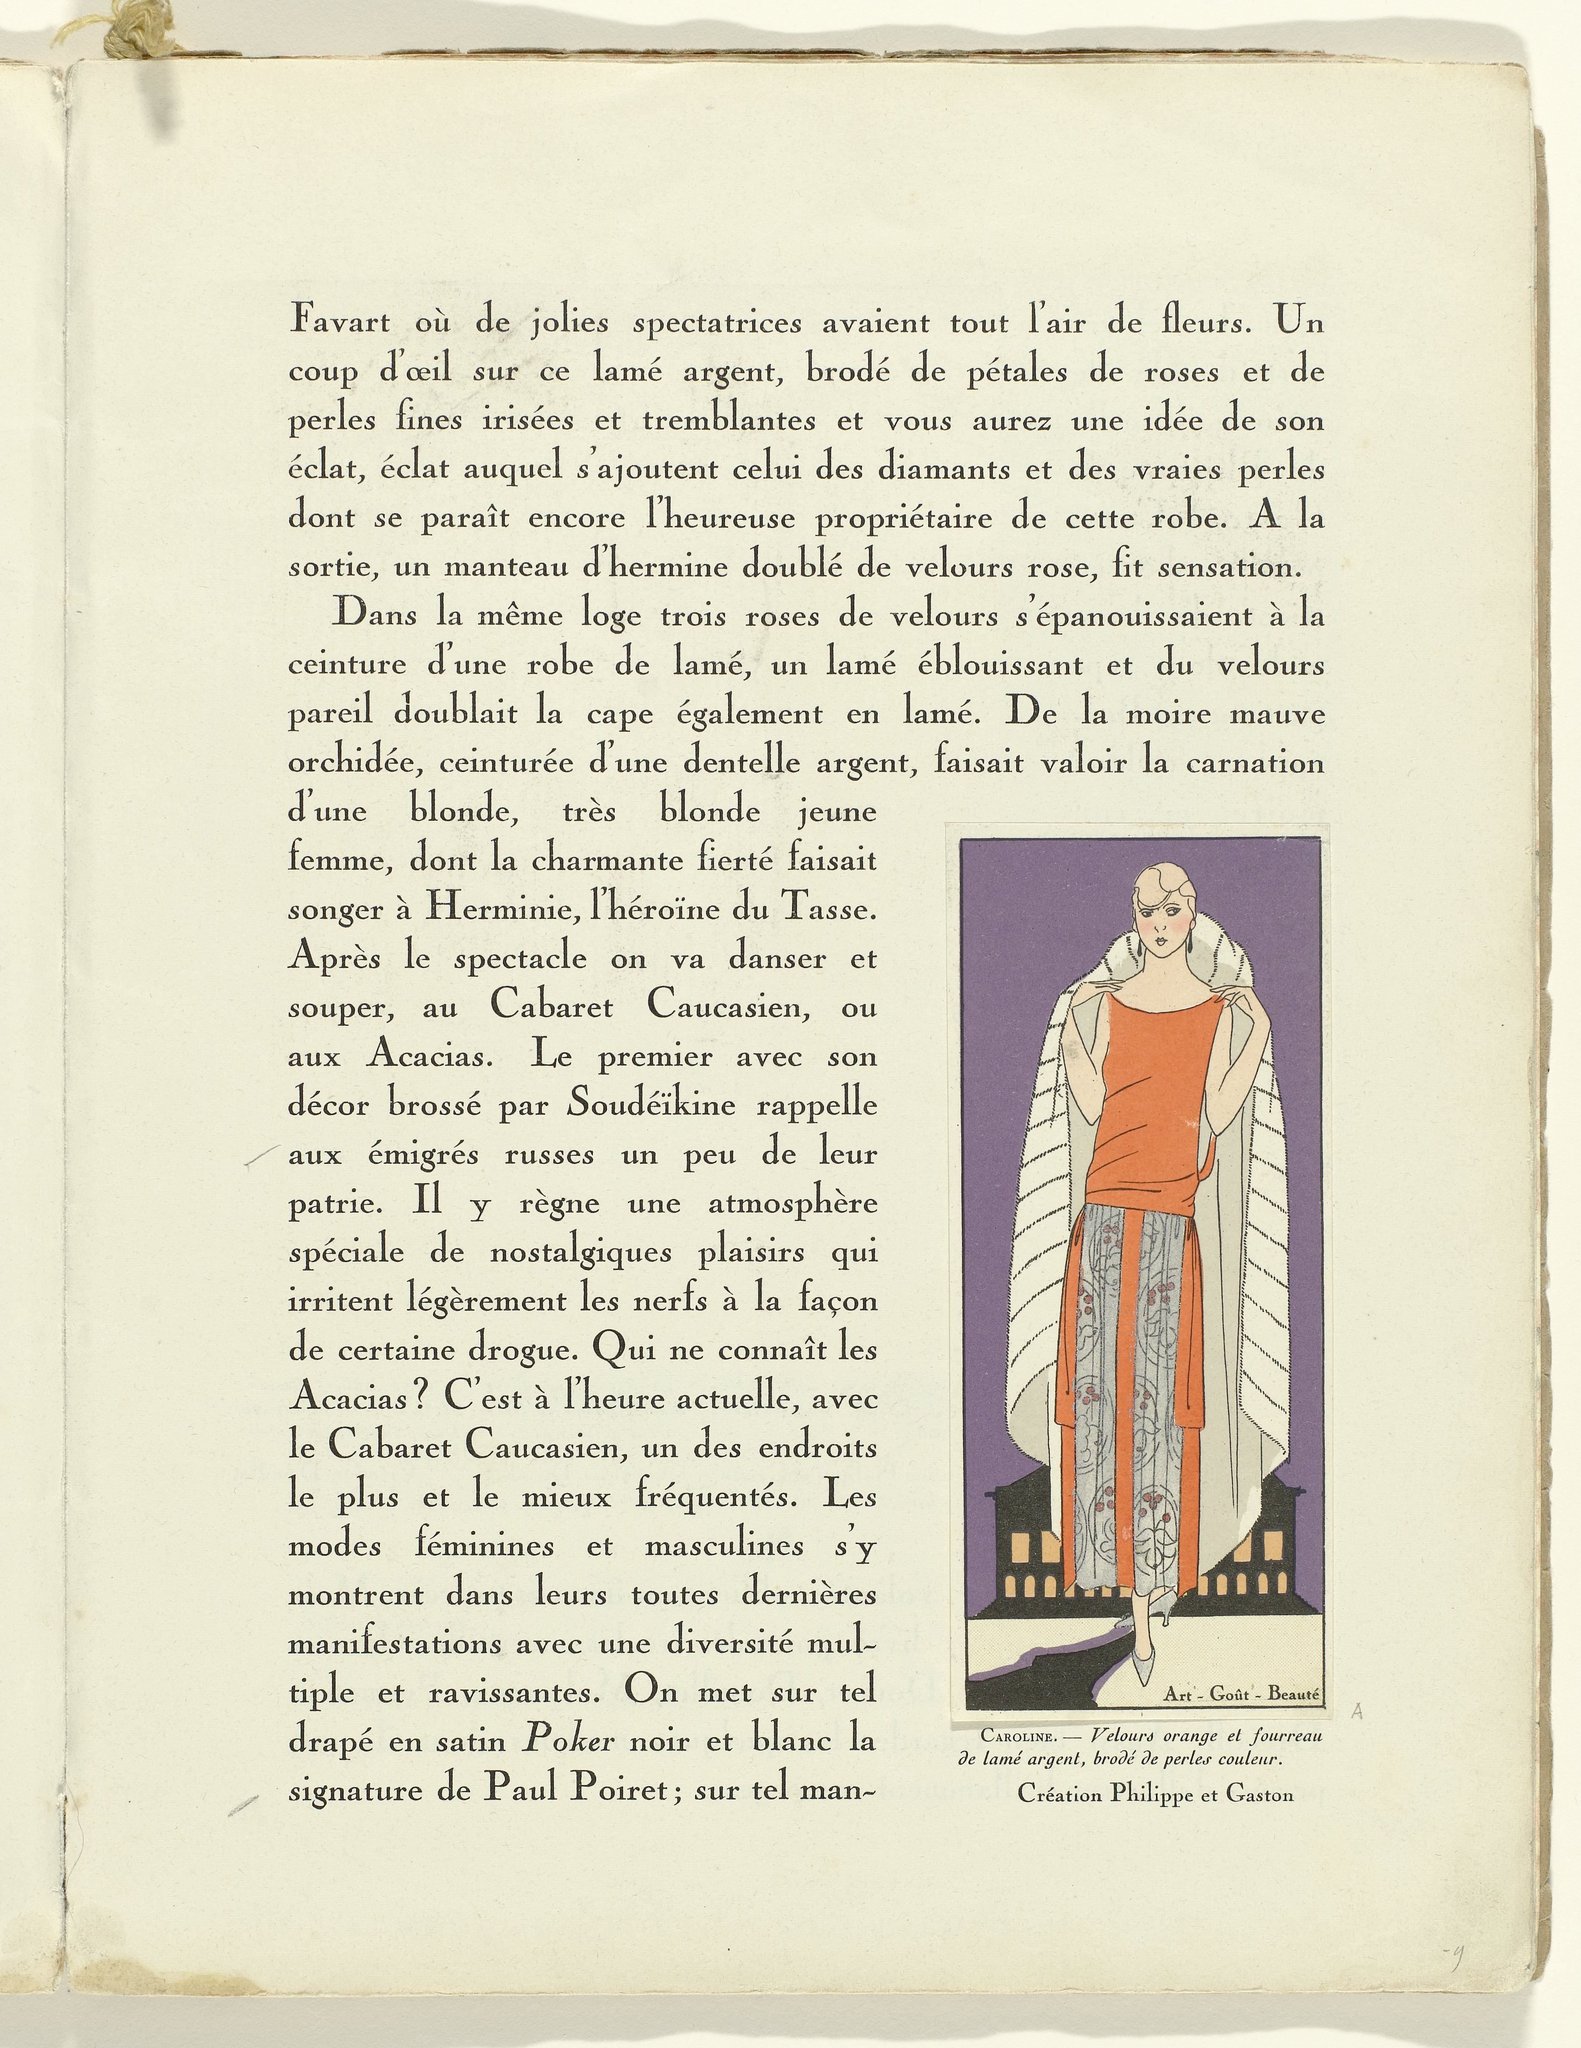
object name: fashion print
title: Art - Goût - Beauté, Feuillets de l' élégance féminine, Janvier 1924, No. 41, 4e Année, p. 9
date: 1924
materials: paper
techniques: brush, hand coloring, lithograph, pochoir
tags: dress, gown (fourreau) (+ women's clothes), embroidery with beads (+ women's clothes), coat (+ fur used for clothes), fashion plates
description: Tekst met een ingeplakte afbeelding. Pagina uit het modetijdschrift Art-Goût-Beauté (1920-1933).